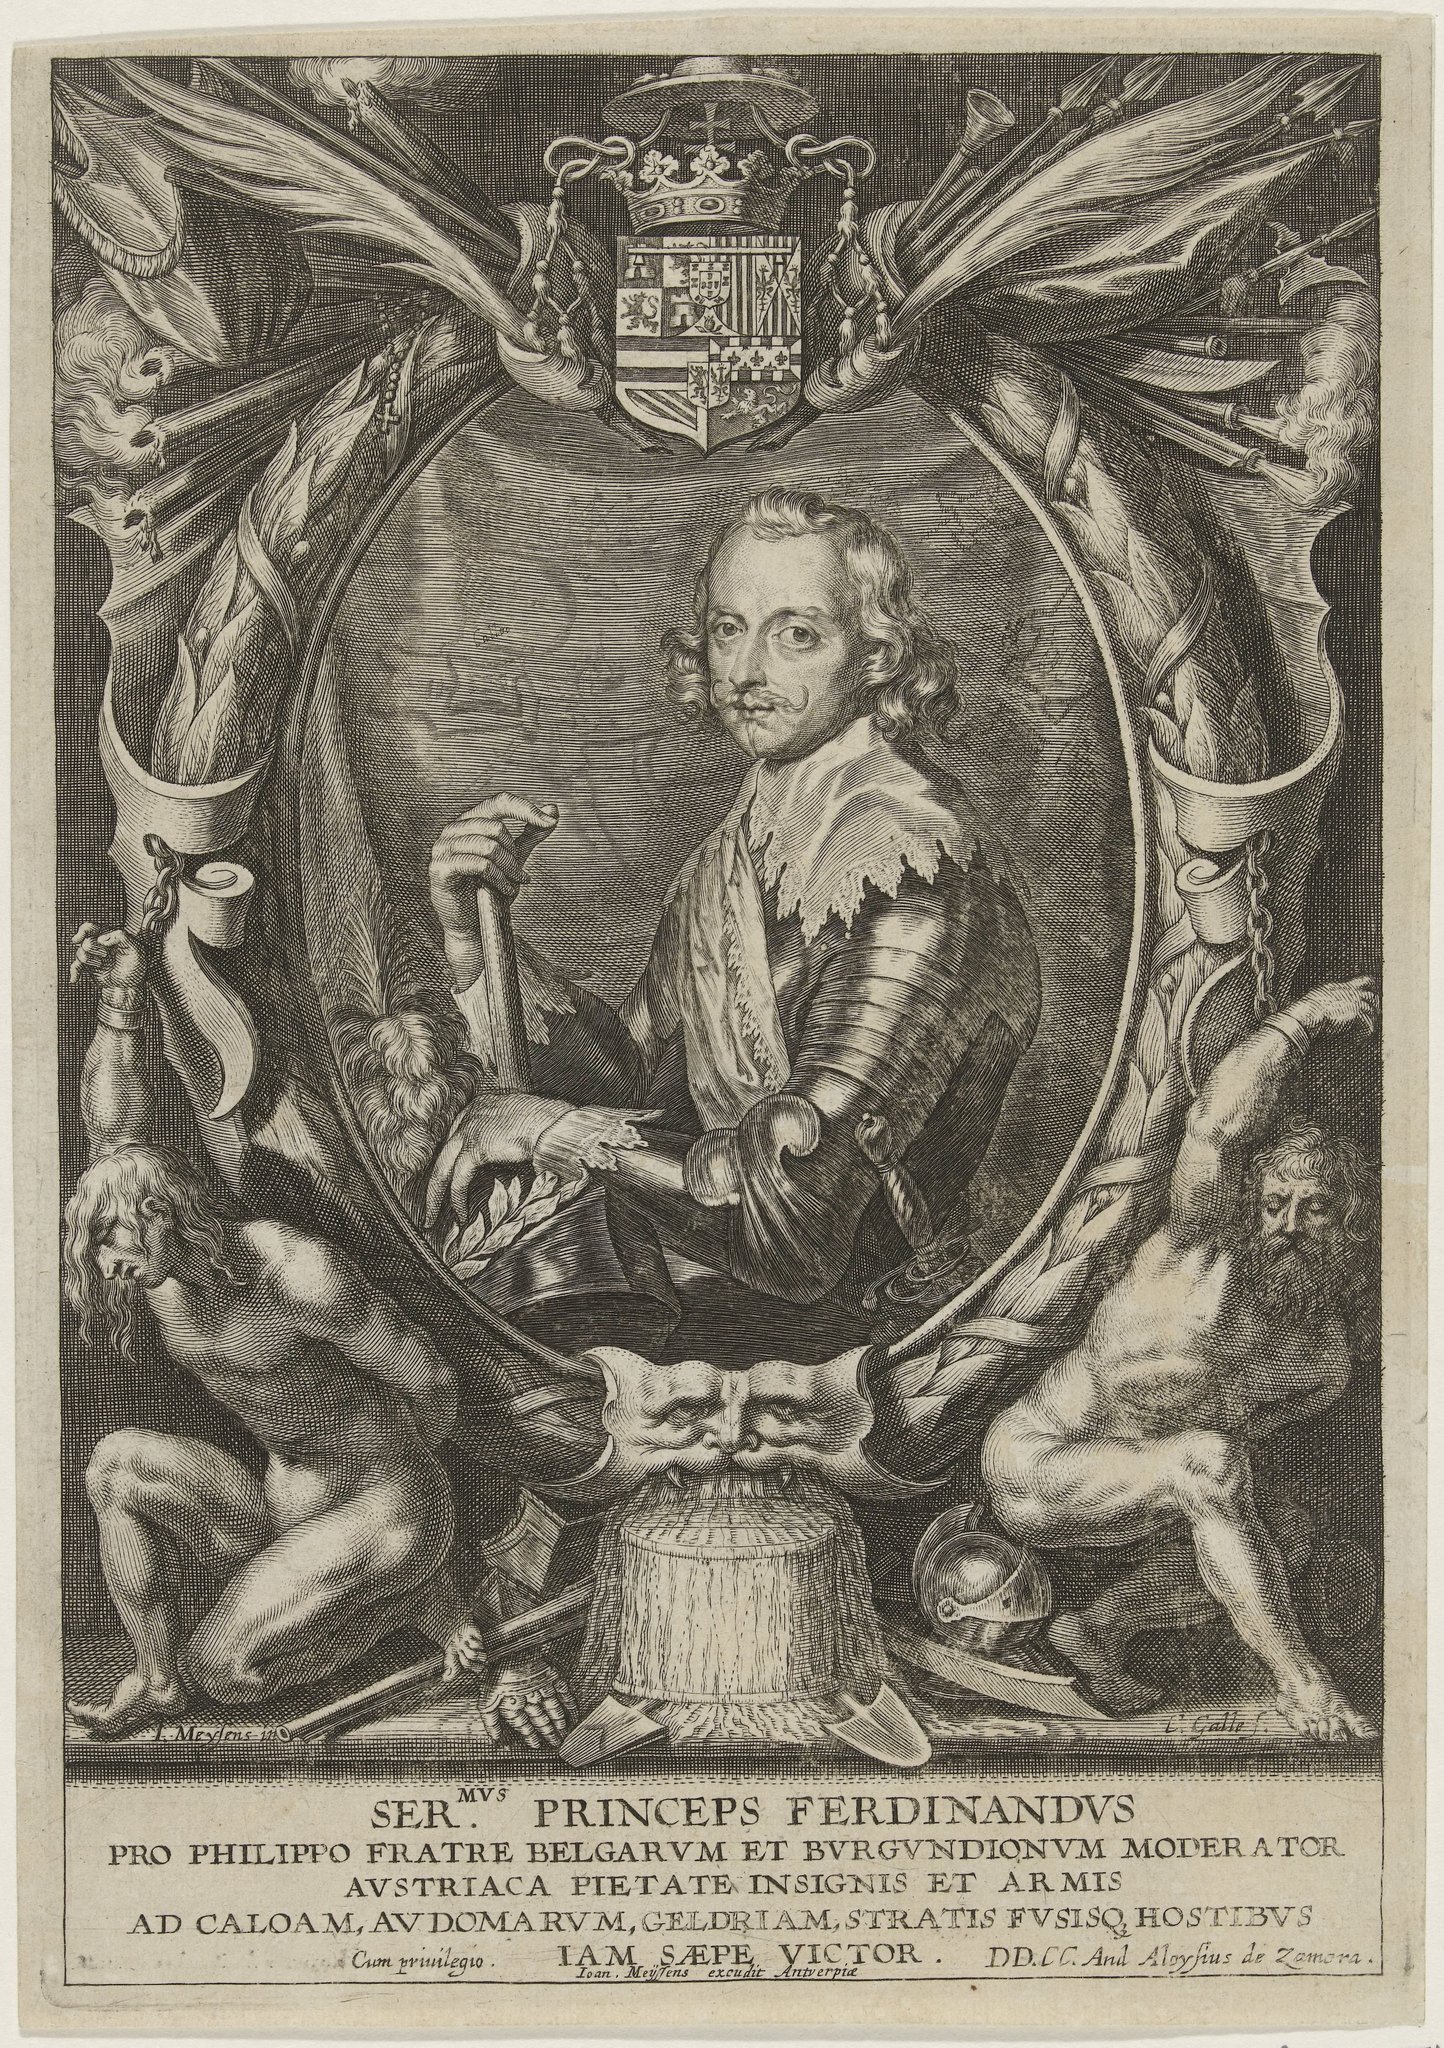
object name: print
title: Portret van Ferdinand van Oostenrijk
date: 1634-1670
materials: paper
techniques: engraving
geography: antwerp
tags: brussels, landvoogd der zuidelijke nederlanden ferdinand van oostenrijk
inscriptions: collector's mark: Lugt 2228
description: Portret van Ferdinand van Oostenrijk, landvoogd van de Zuidelijke Nederlanden, in ovaal met ornamentele omlijsting. Boven het portret zijn kardinaalswapen. Ferdinand houdt een commandostaf vast e zit voor een landkaart.